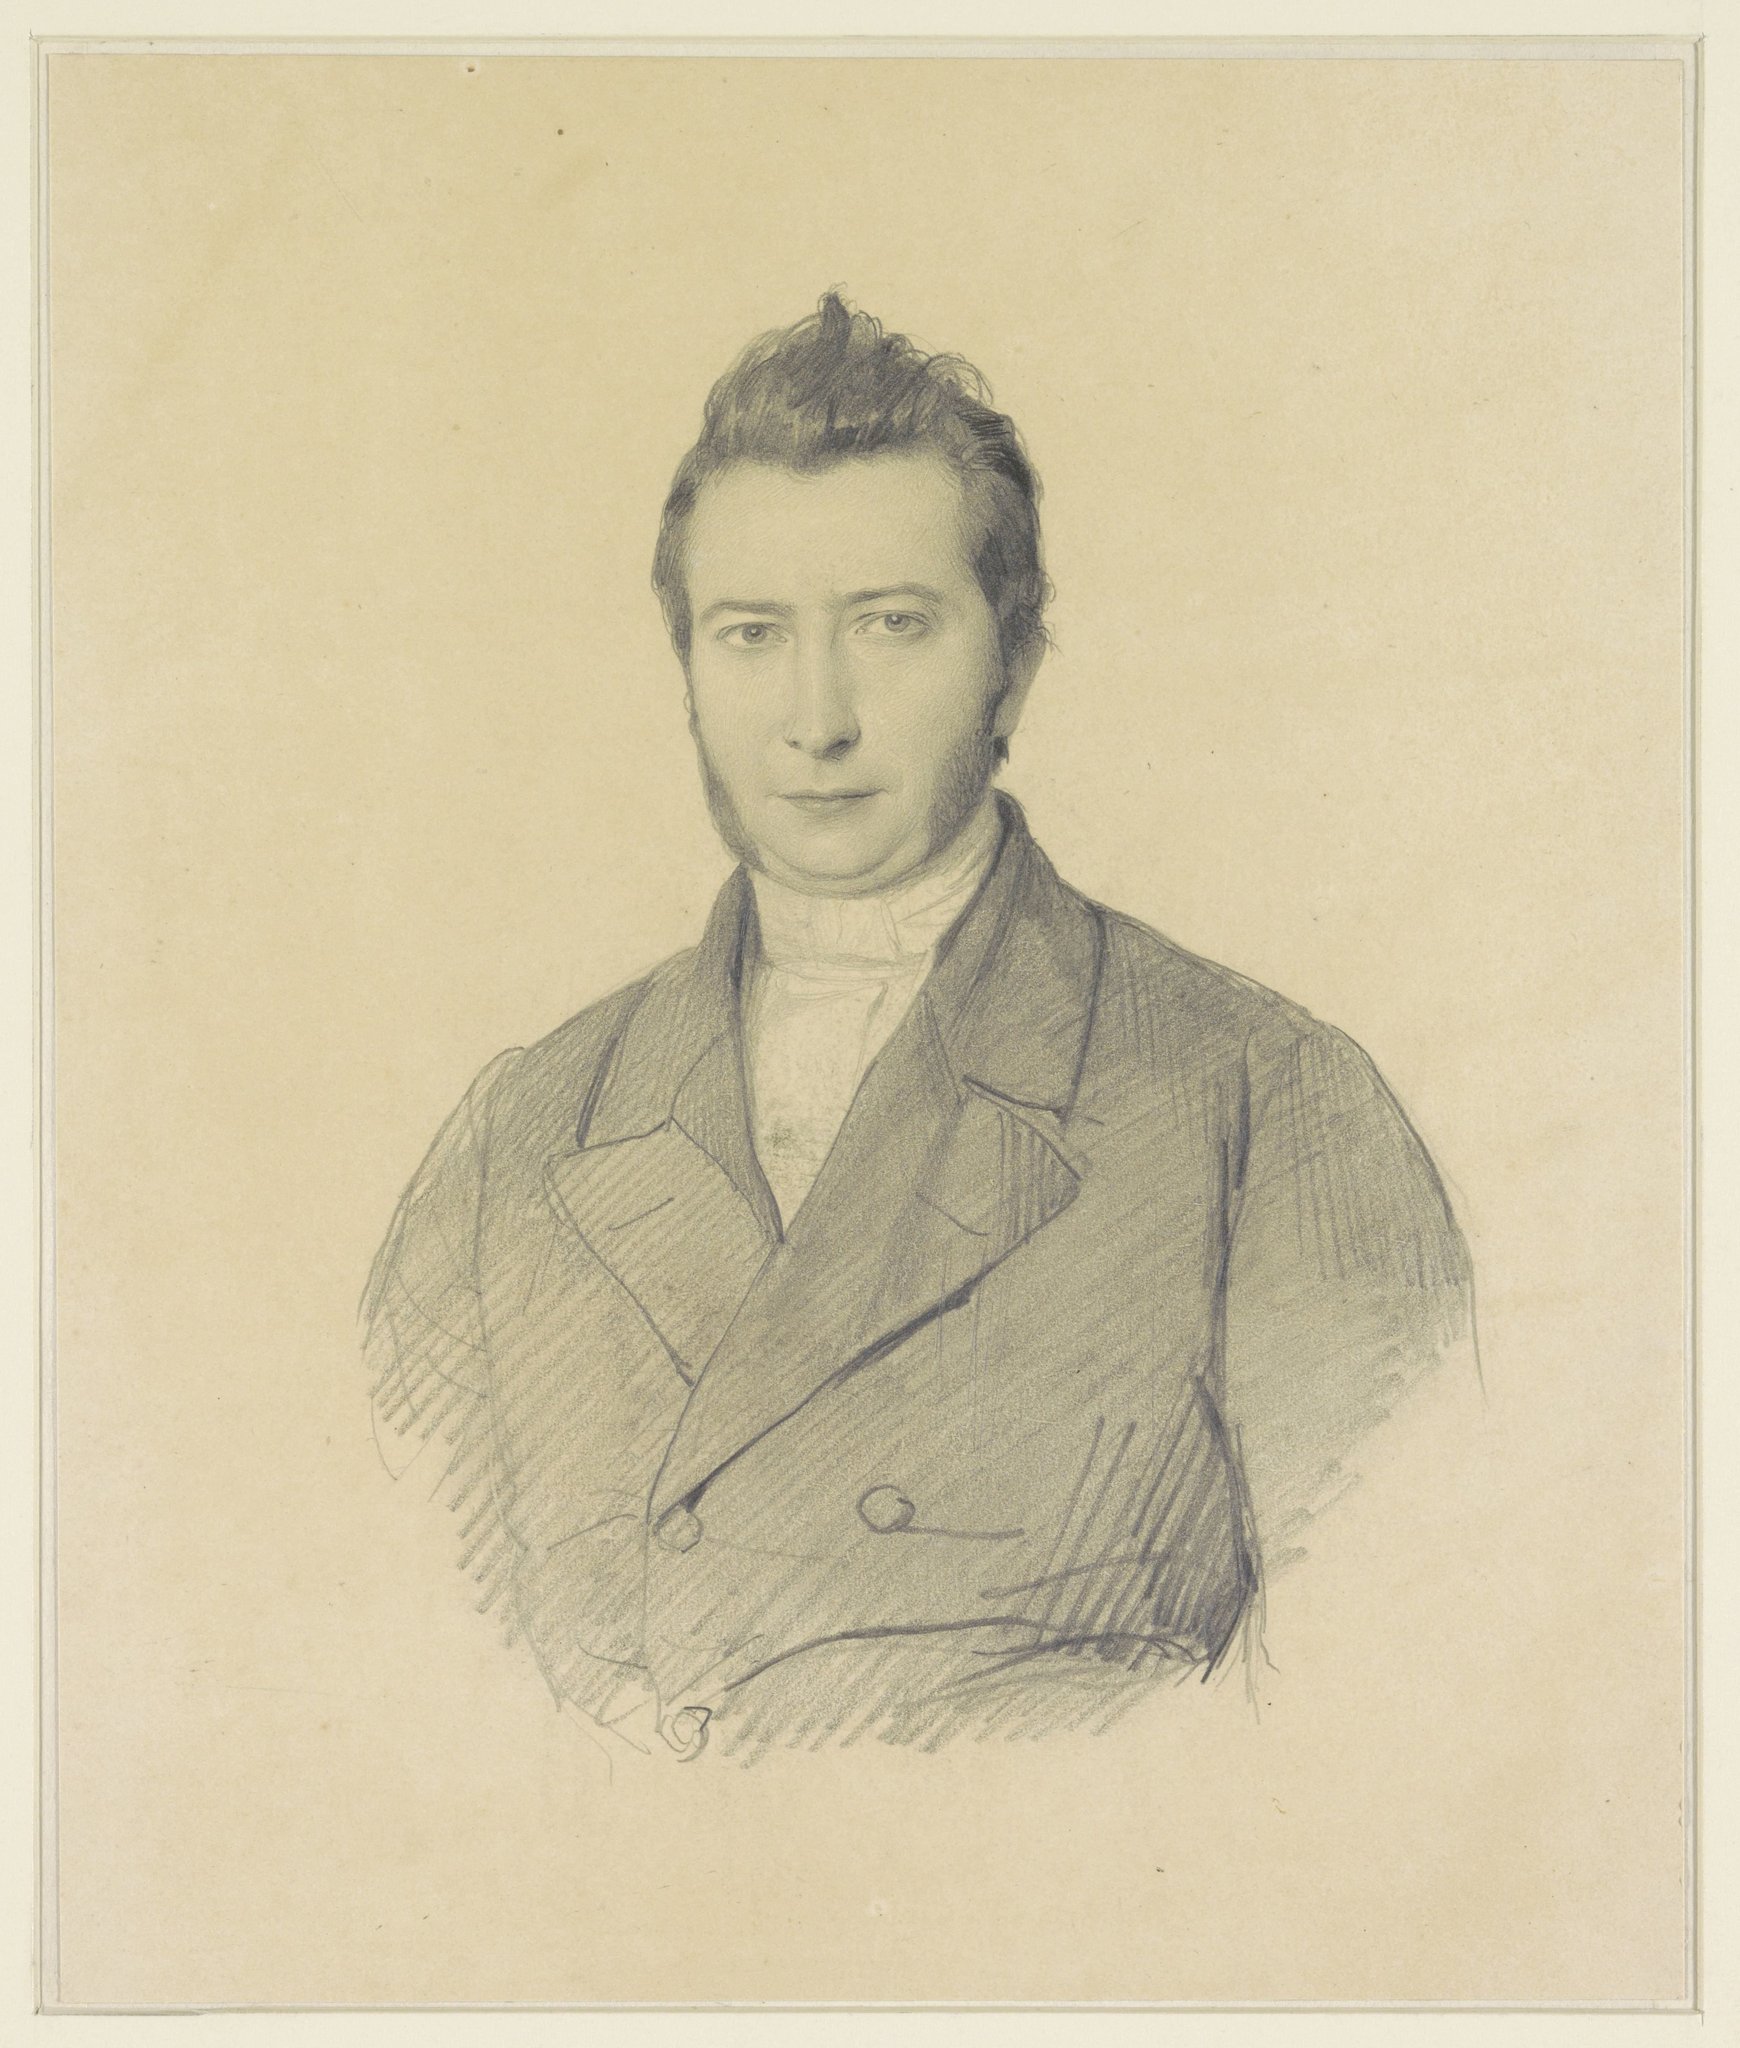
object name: drawing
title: Portret van de schrijver Jan Jacob Lodewijk ten Kate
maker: gerhardus fredericus eilbracht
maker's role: draughtsman, print maker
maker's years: 1816-1854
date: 1826-1854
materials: paper, pencil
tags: the hague, amsterdam, jan jakob lodewijk ten kate, historical persons, portrait of a writer, portrait, self-portrait of artist